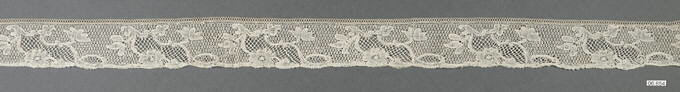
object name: fragment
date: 1701-1800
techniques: lace